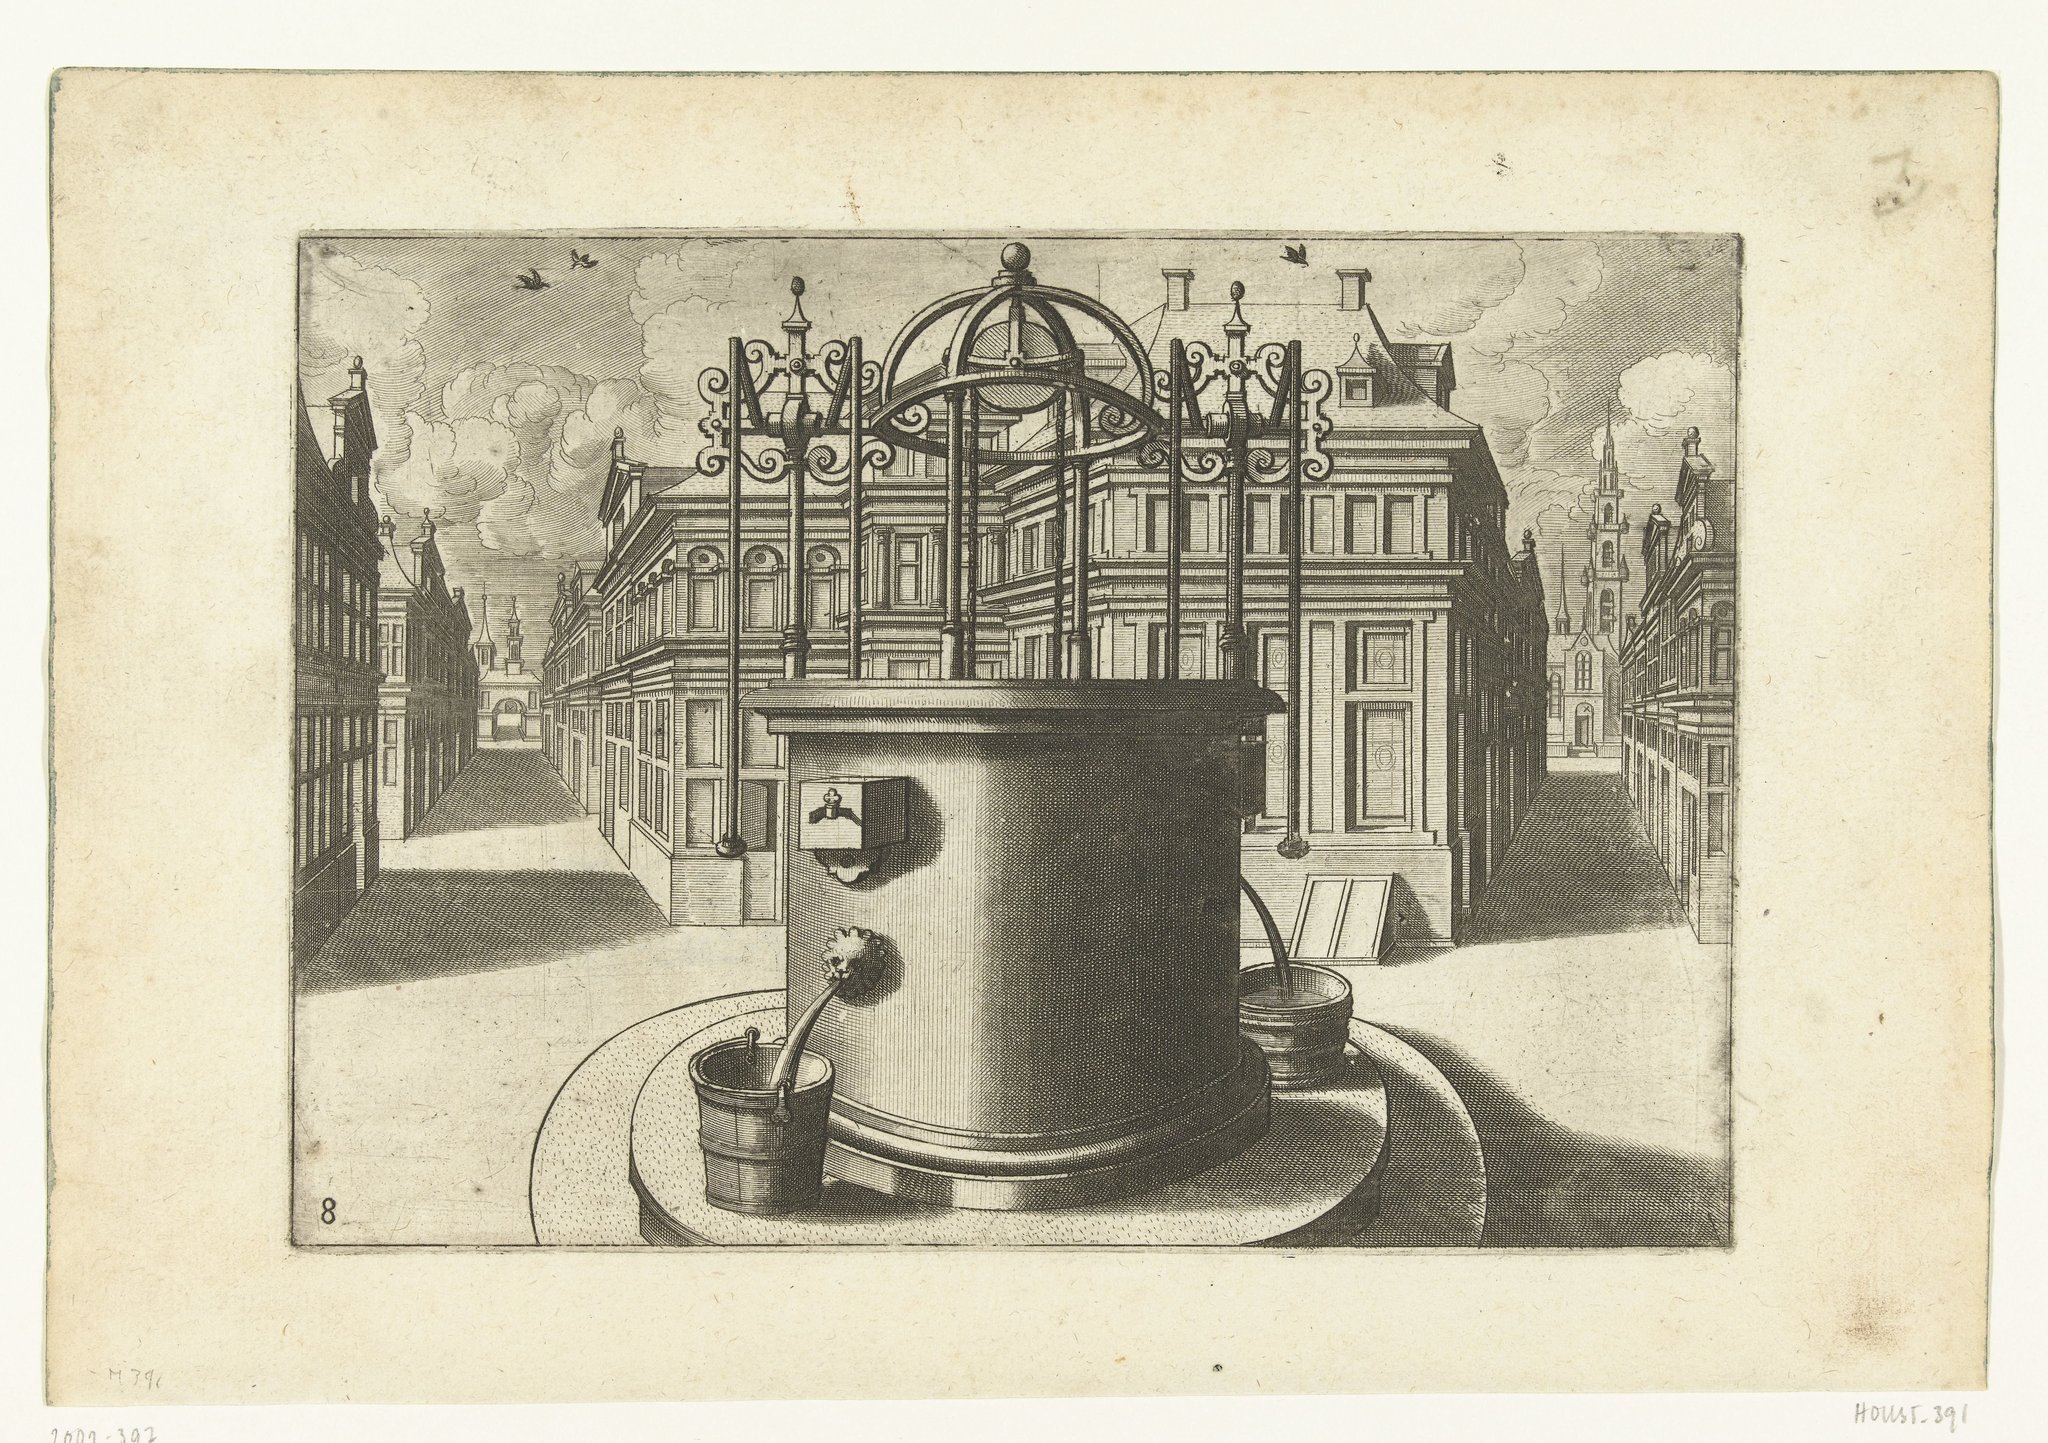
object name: ornament print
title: Waterputten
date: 1574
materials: paper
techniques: etching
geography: antwerp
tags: well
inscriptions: number: ‘8’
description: Een hoge ronde put met ijzeren ornamentele overhuiving waaruit zowel via een katrol als via pompzwengels water geput kan worden. Aan twee kanten een emmer. De put staat op een stadsplein met gezicht in twee straten. No.8 uit serie van 24 kleine waterputten